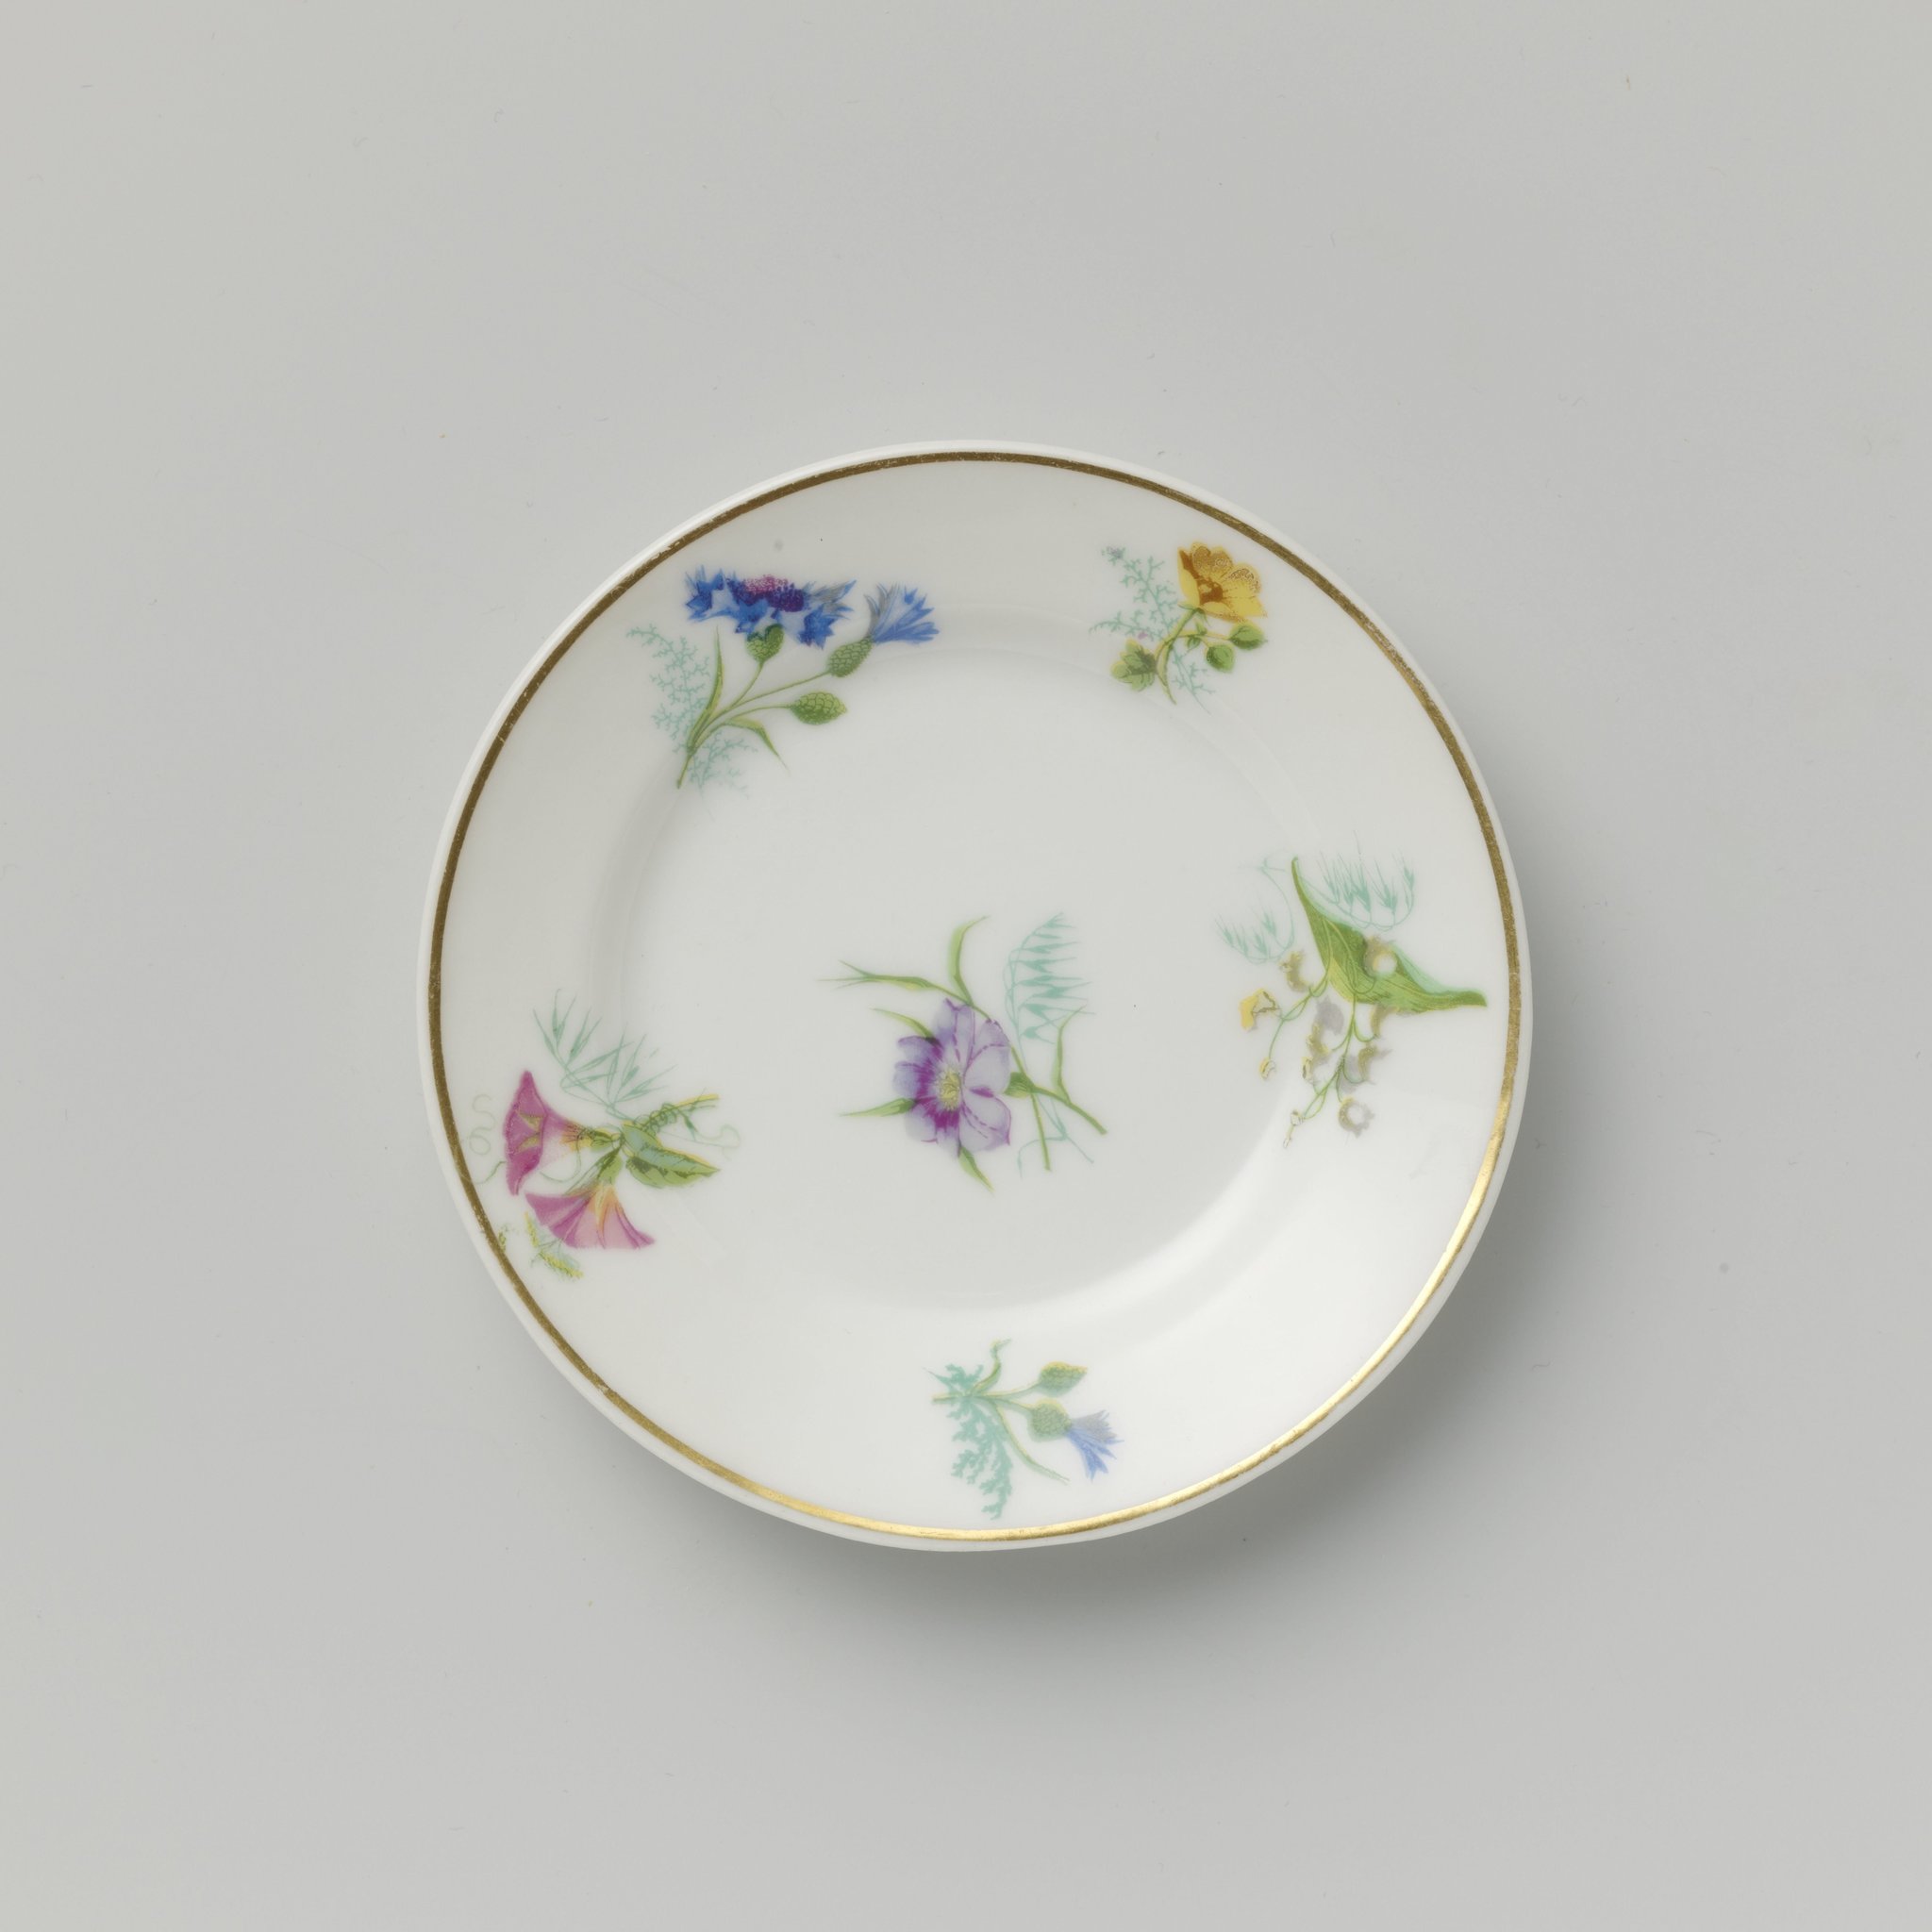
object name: kinderservies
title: Plate with various flower sprays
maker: Anonymous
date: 1850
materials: glaze, gold, paint, porcelain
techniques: firing, forming, gilding, turning, vitrification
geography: france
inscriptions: mark: ‘twee cijfers of letters?’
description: Bord van porselein, versierd op het glazuur met blauw, rood, roze, groen, geel, paars en goud. Op de voorzijde verschillende bloemtakken en een gouden lijn op de rand. Gemerkt op de onderzijde met twee onleesbare cijfers of letters.